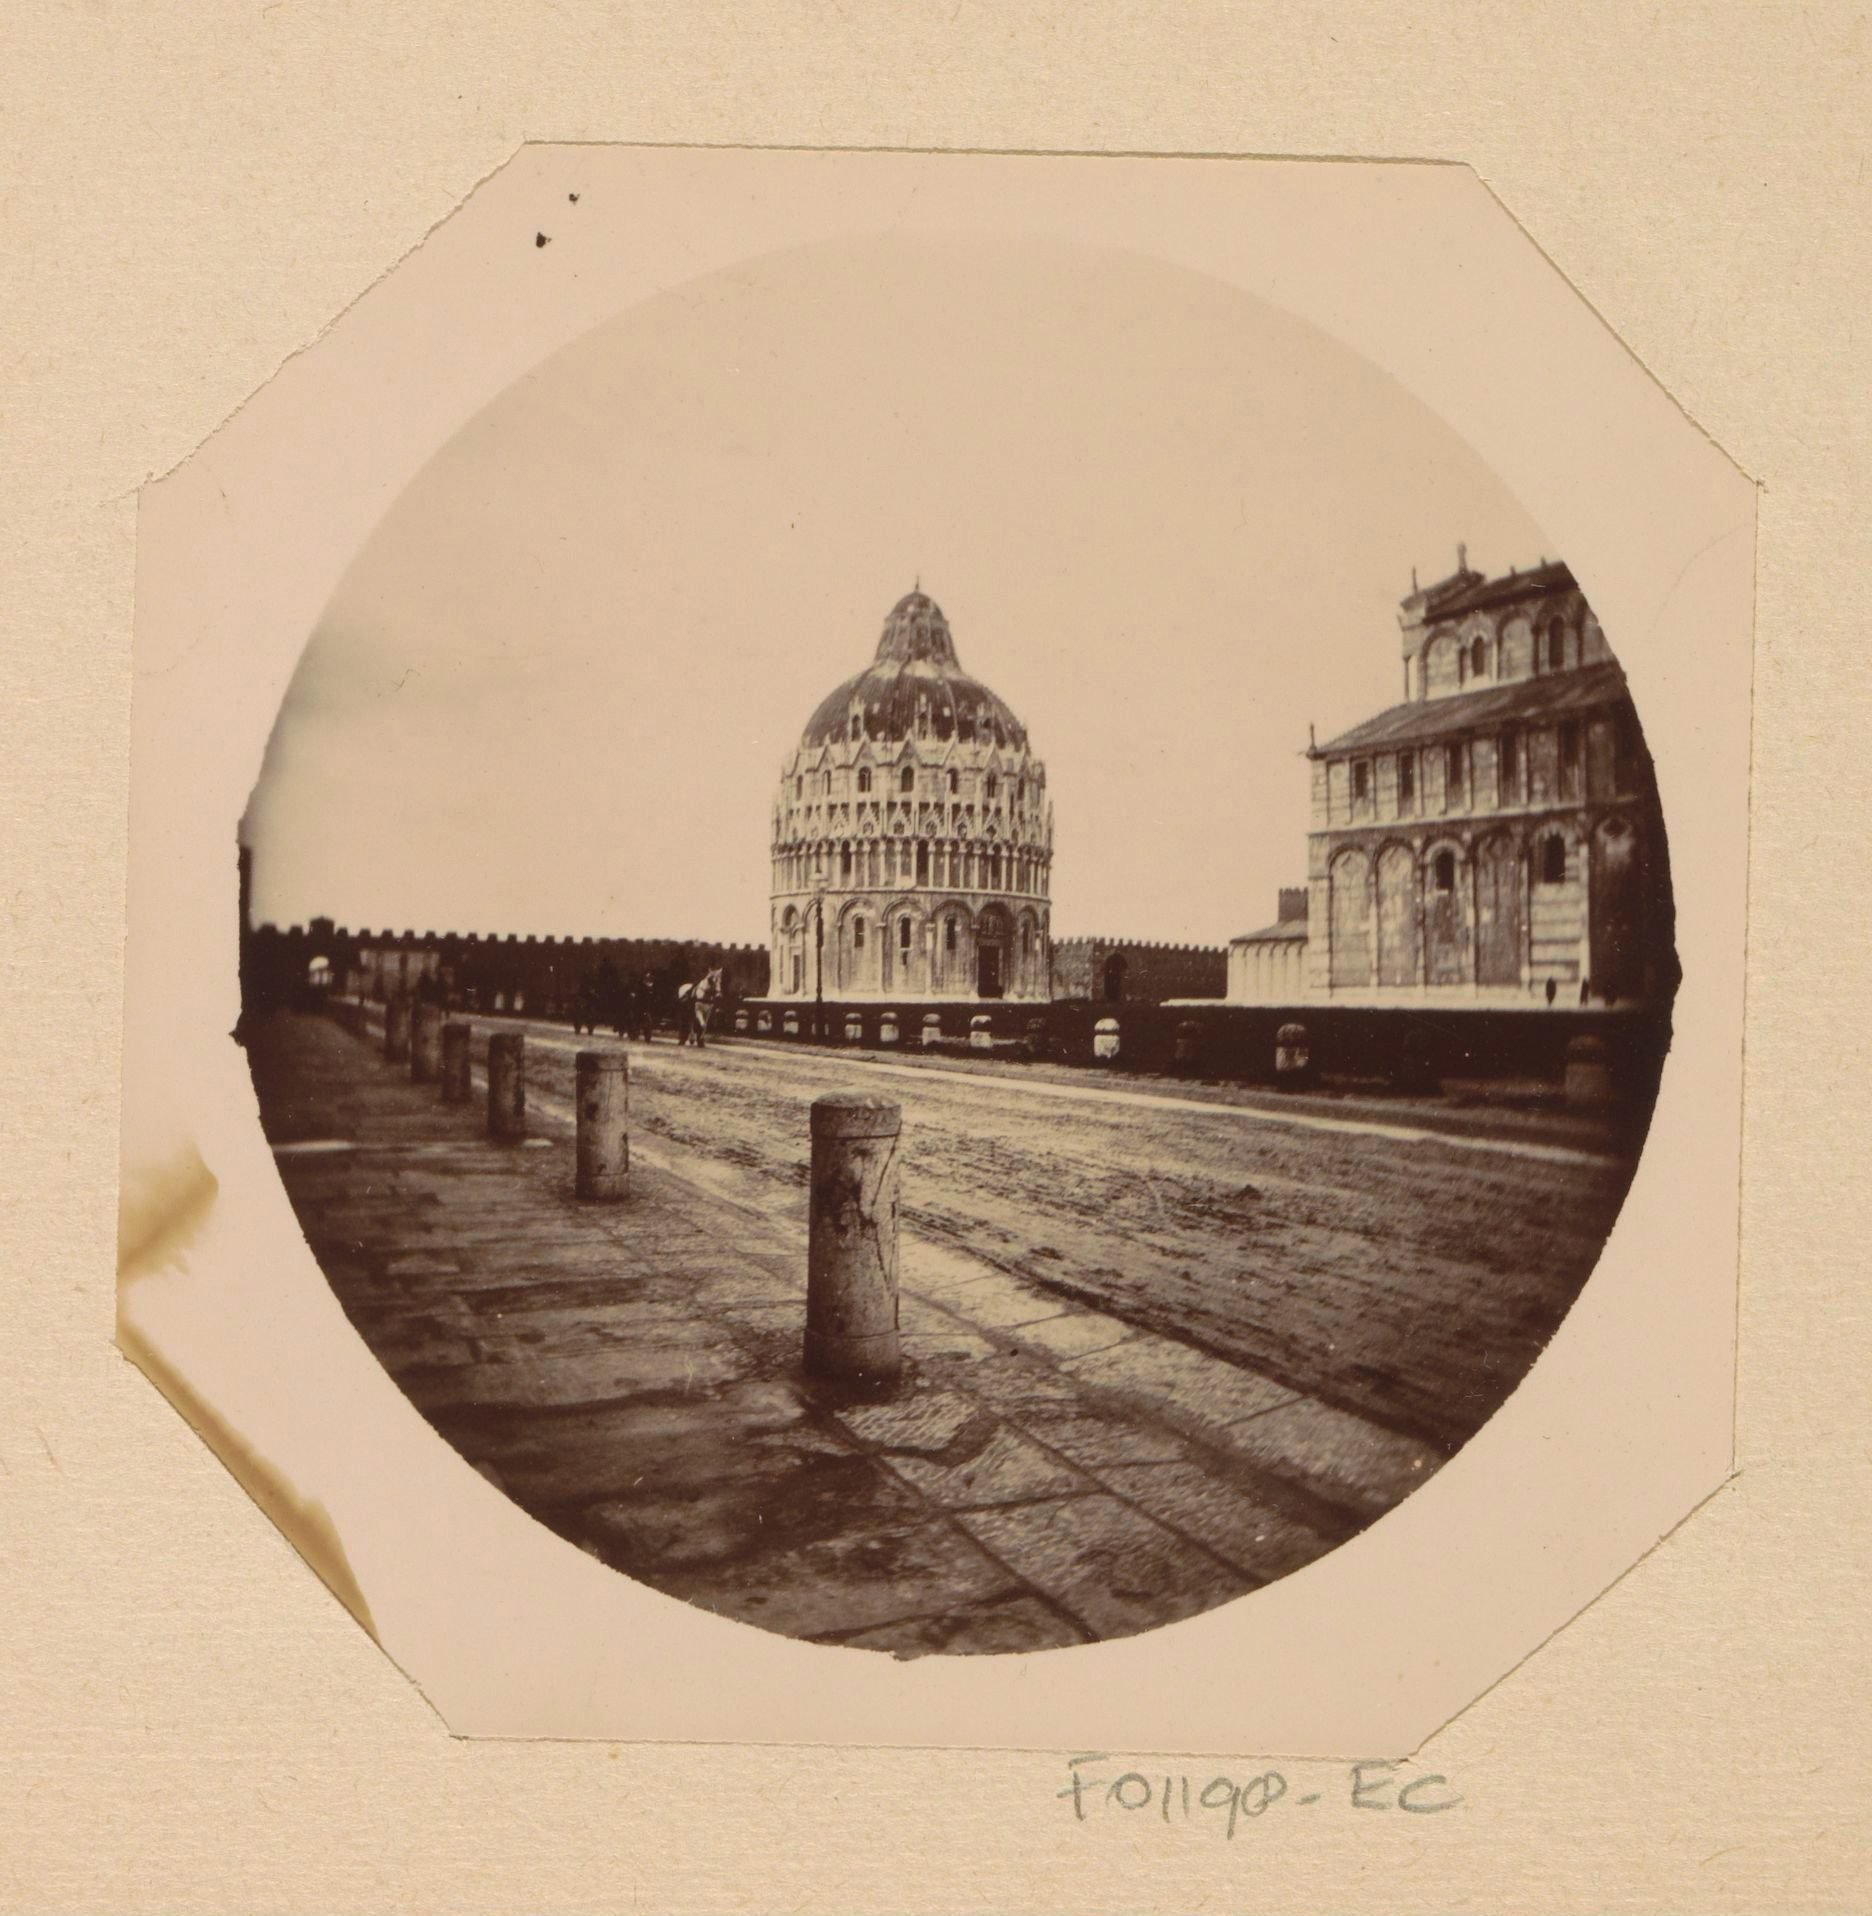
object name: photograph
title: Pisa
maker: johanna margaretha piek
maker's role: fotograaf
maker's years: 1870-1947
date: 1889-1893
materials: paper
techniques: gelatin silver print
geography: pisa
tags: parts of church exterior and annexes: chapel